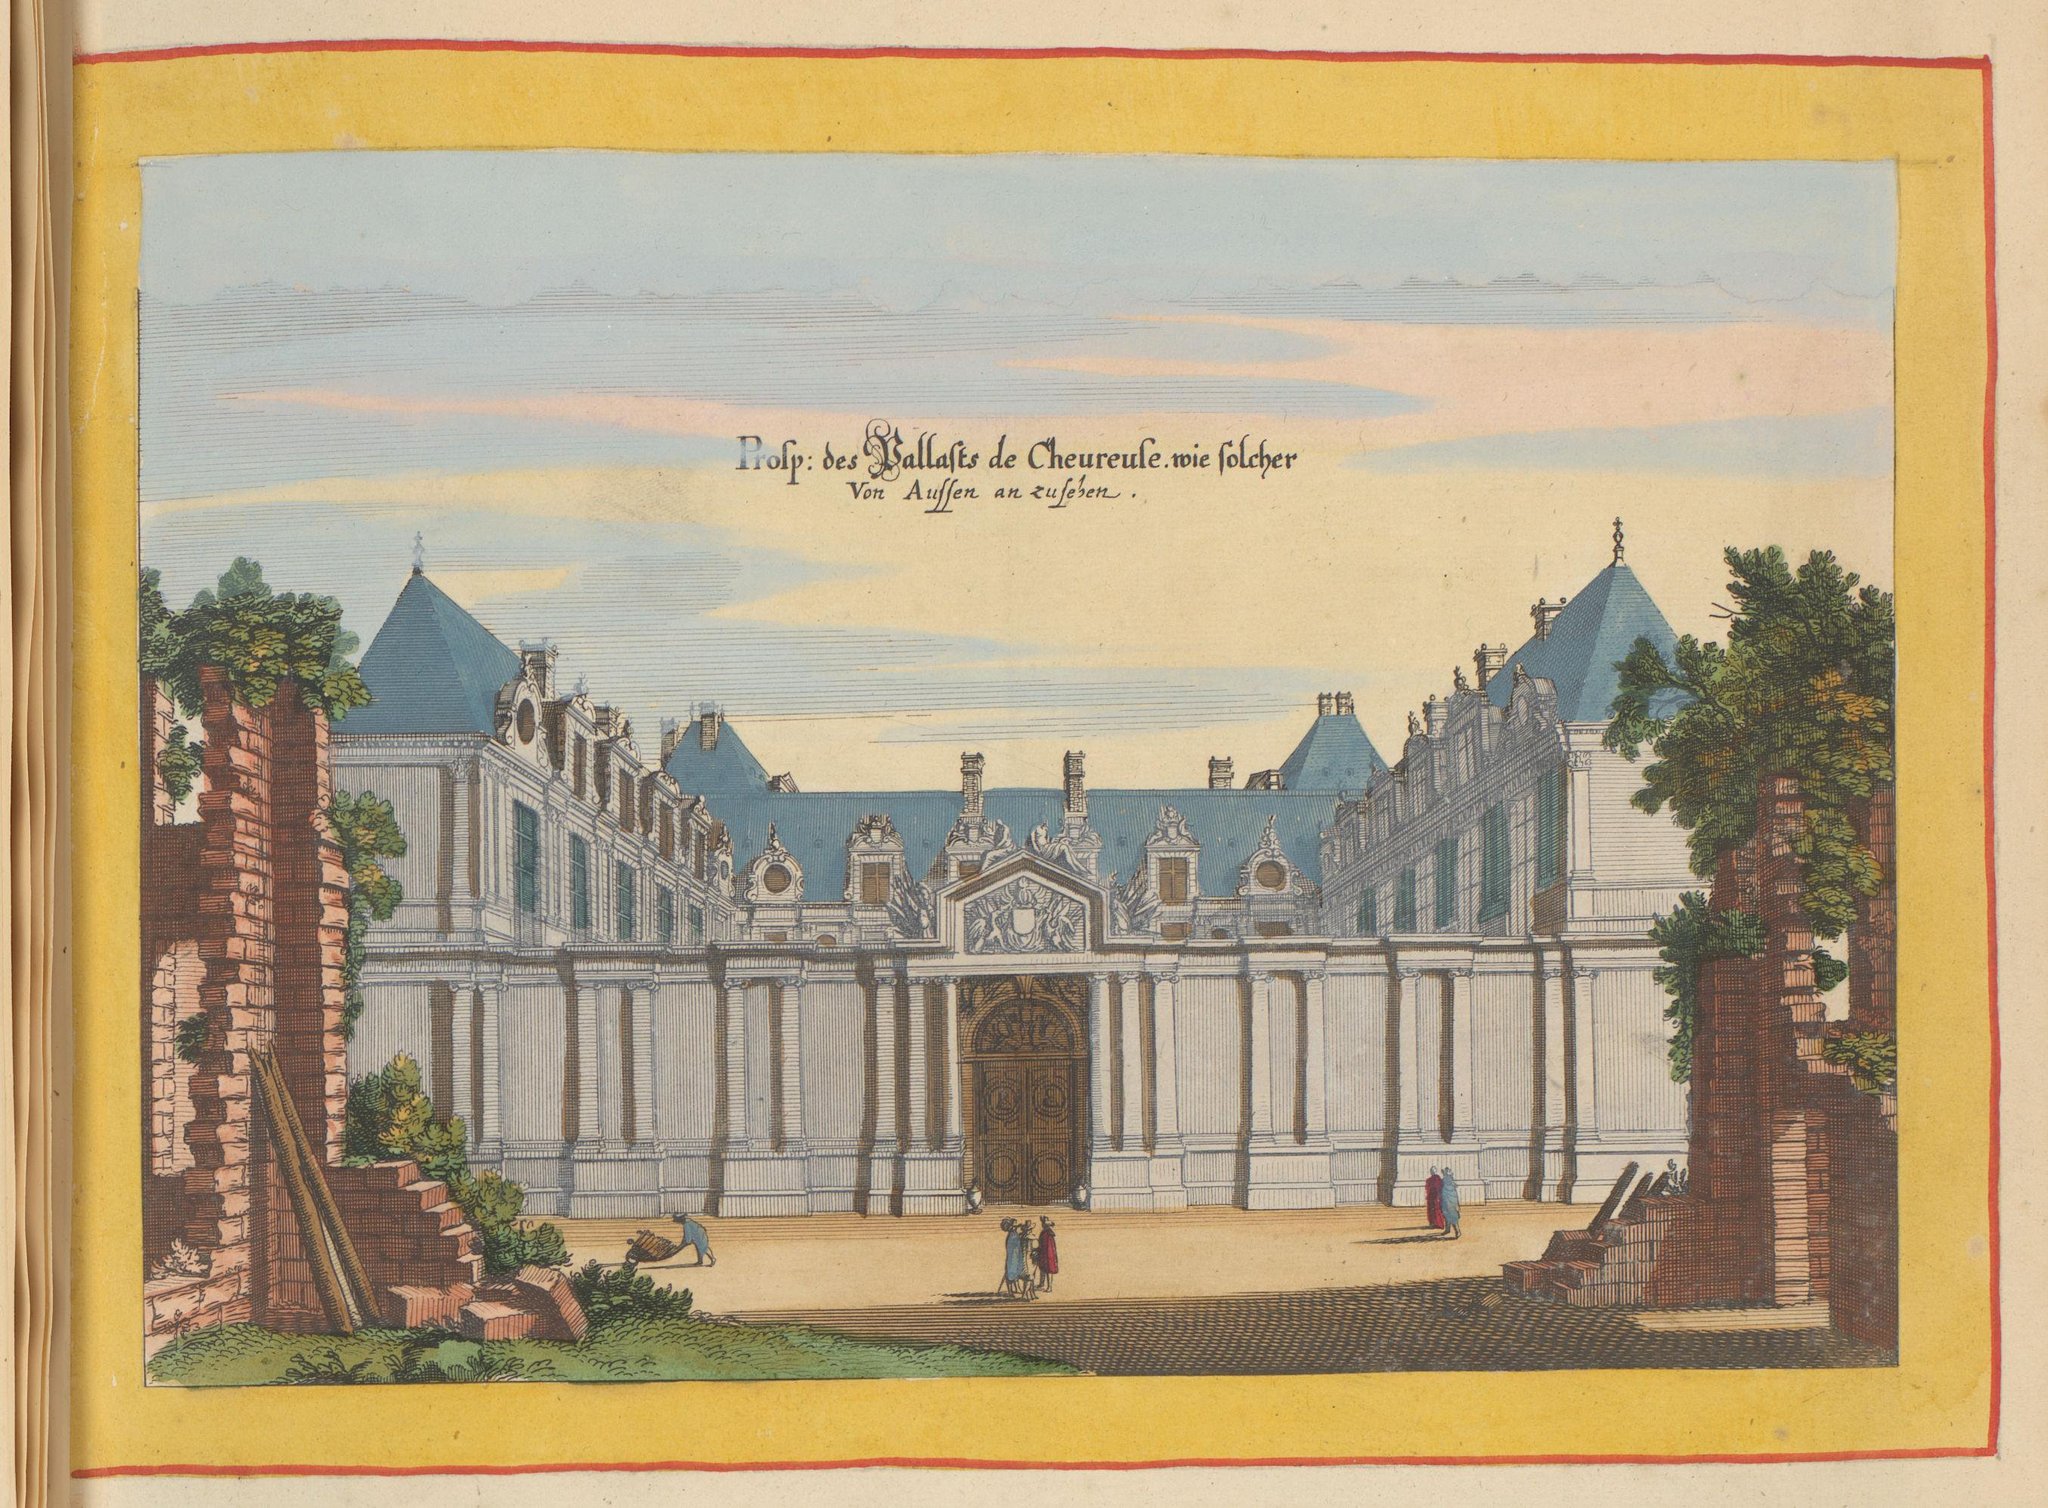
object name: print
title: Prosp. dess Pallasts de Chevreuse wie solcher von aussen an zusehen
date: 1655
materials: paper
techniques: engraving, etching, hand coloring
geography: the hague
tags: hôtel, i.e. small palace in city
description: Prent origineel vervaardigd als boekillustratie voor: Zeiller, Martin. Topographia Galliae, oder Beschreibung und Contrafaitung der vornehmbsten und bekantisten Oerter in dem mächtigen und grossen Königreich Frankreich, 13 delen. Frankfurt am Main: Caspar Merian, 1655-1661. De prent werd voor het eerst gepubliceerd in deel 1: Topographia Galliae, 1655. De prent is langs de bovenrand van de voorstelling afgescheurd. De voorstelling is aan de bovenzijde aangevuld met een geschilderde lucht.